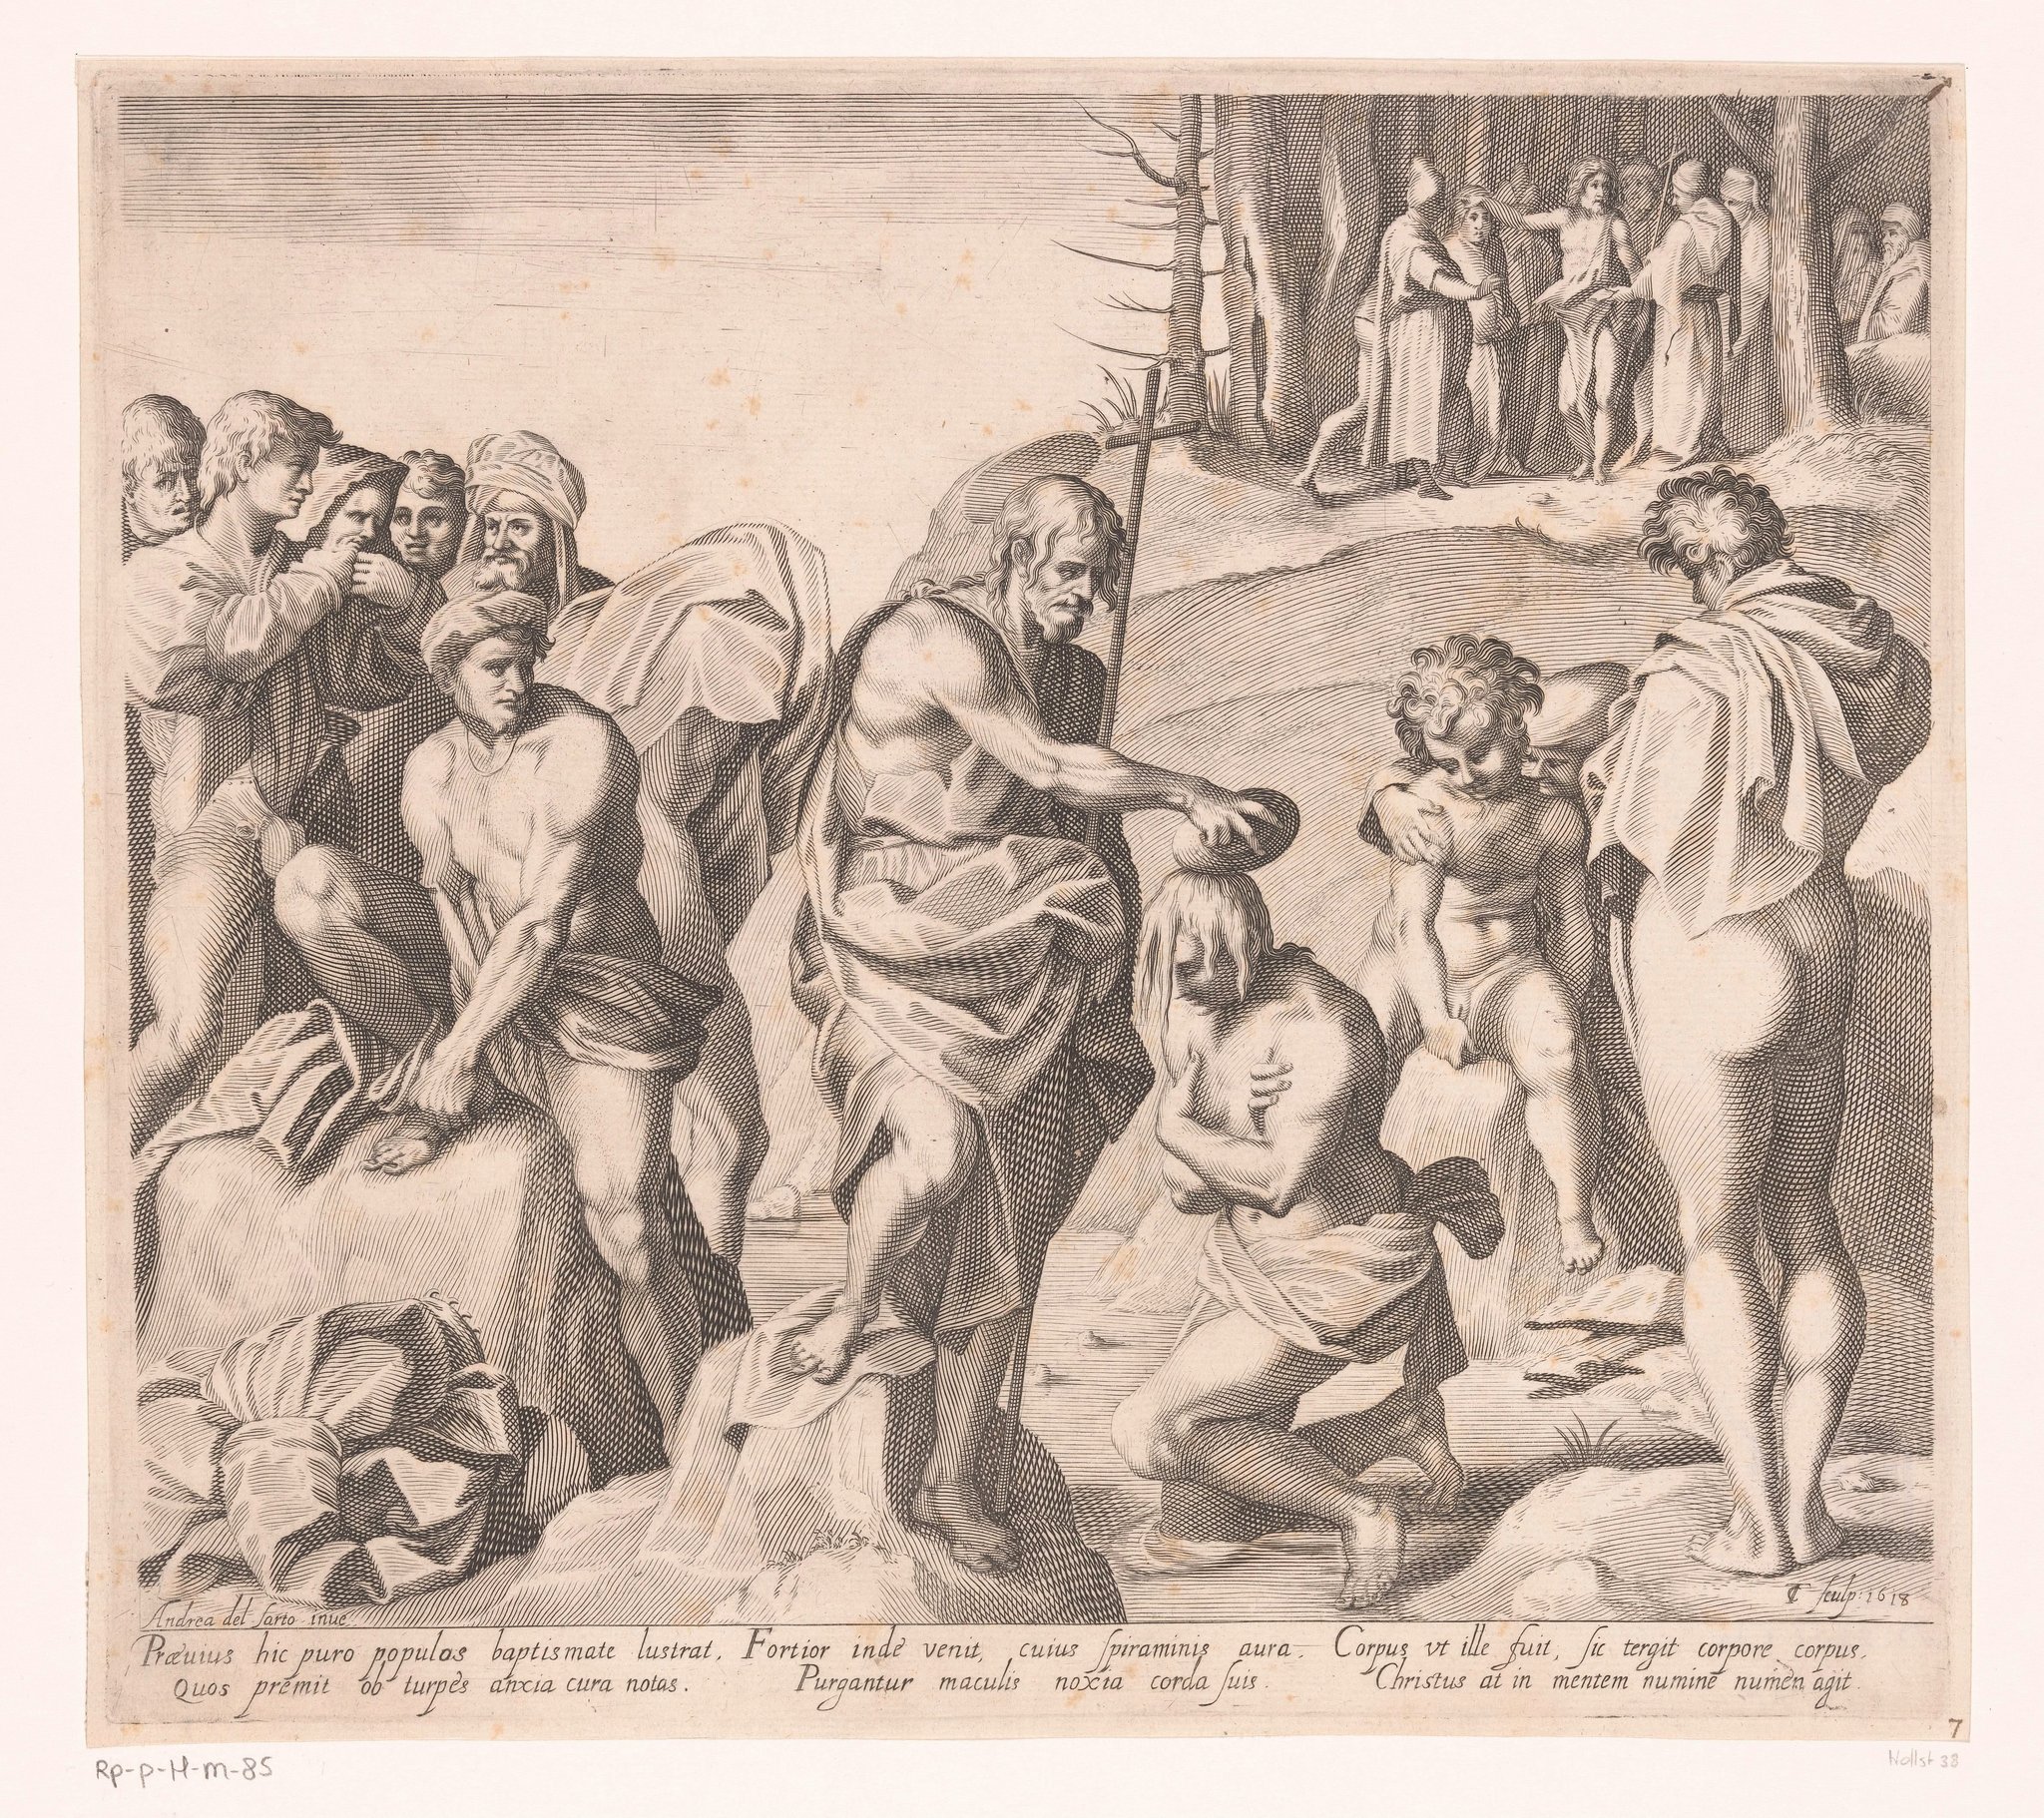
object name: print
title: Scènes uit het leven van Johannes de Doper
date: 1617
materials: paper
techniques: engraving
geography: florence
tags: john the baptist baptizing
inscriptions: collector's mark: Lugt 11, collector's mark: ‘Hinloopen’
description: Onderdeel van een serie van dertien prenten en een titelprent. Het jaartal is met inkt veranderd naar 1618. Origineel onderdeel geweest van het album Schijnvoet-nummer 24.